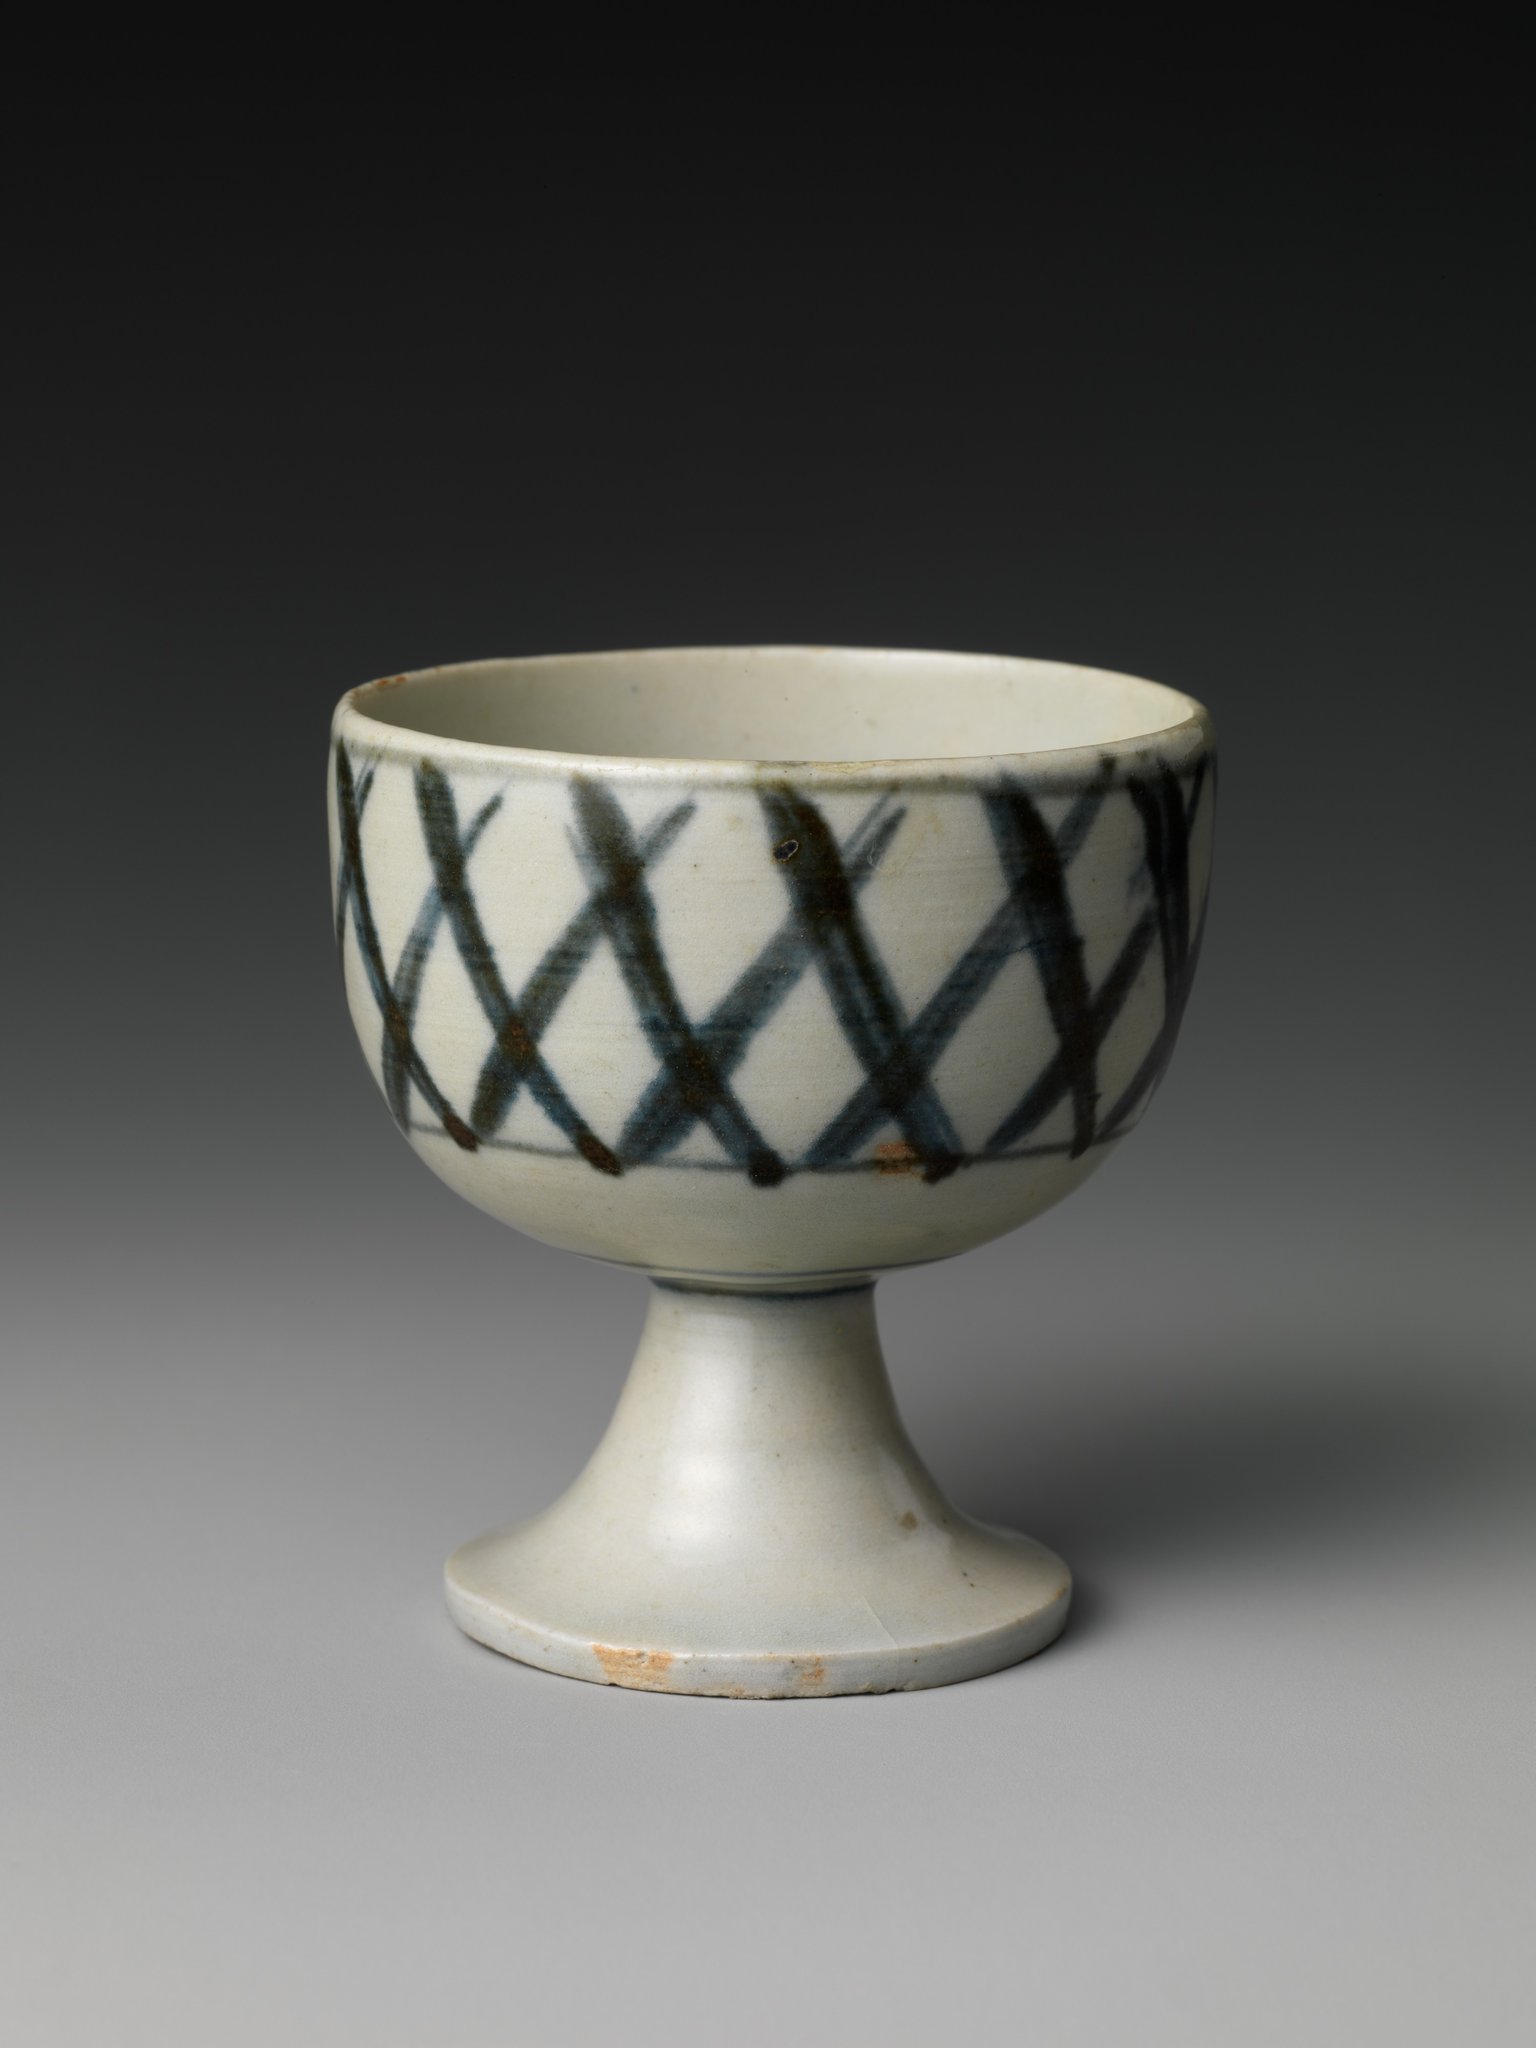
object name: cup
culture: japanese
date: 1615-1868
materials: porcelain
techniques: underglaze